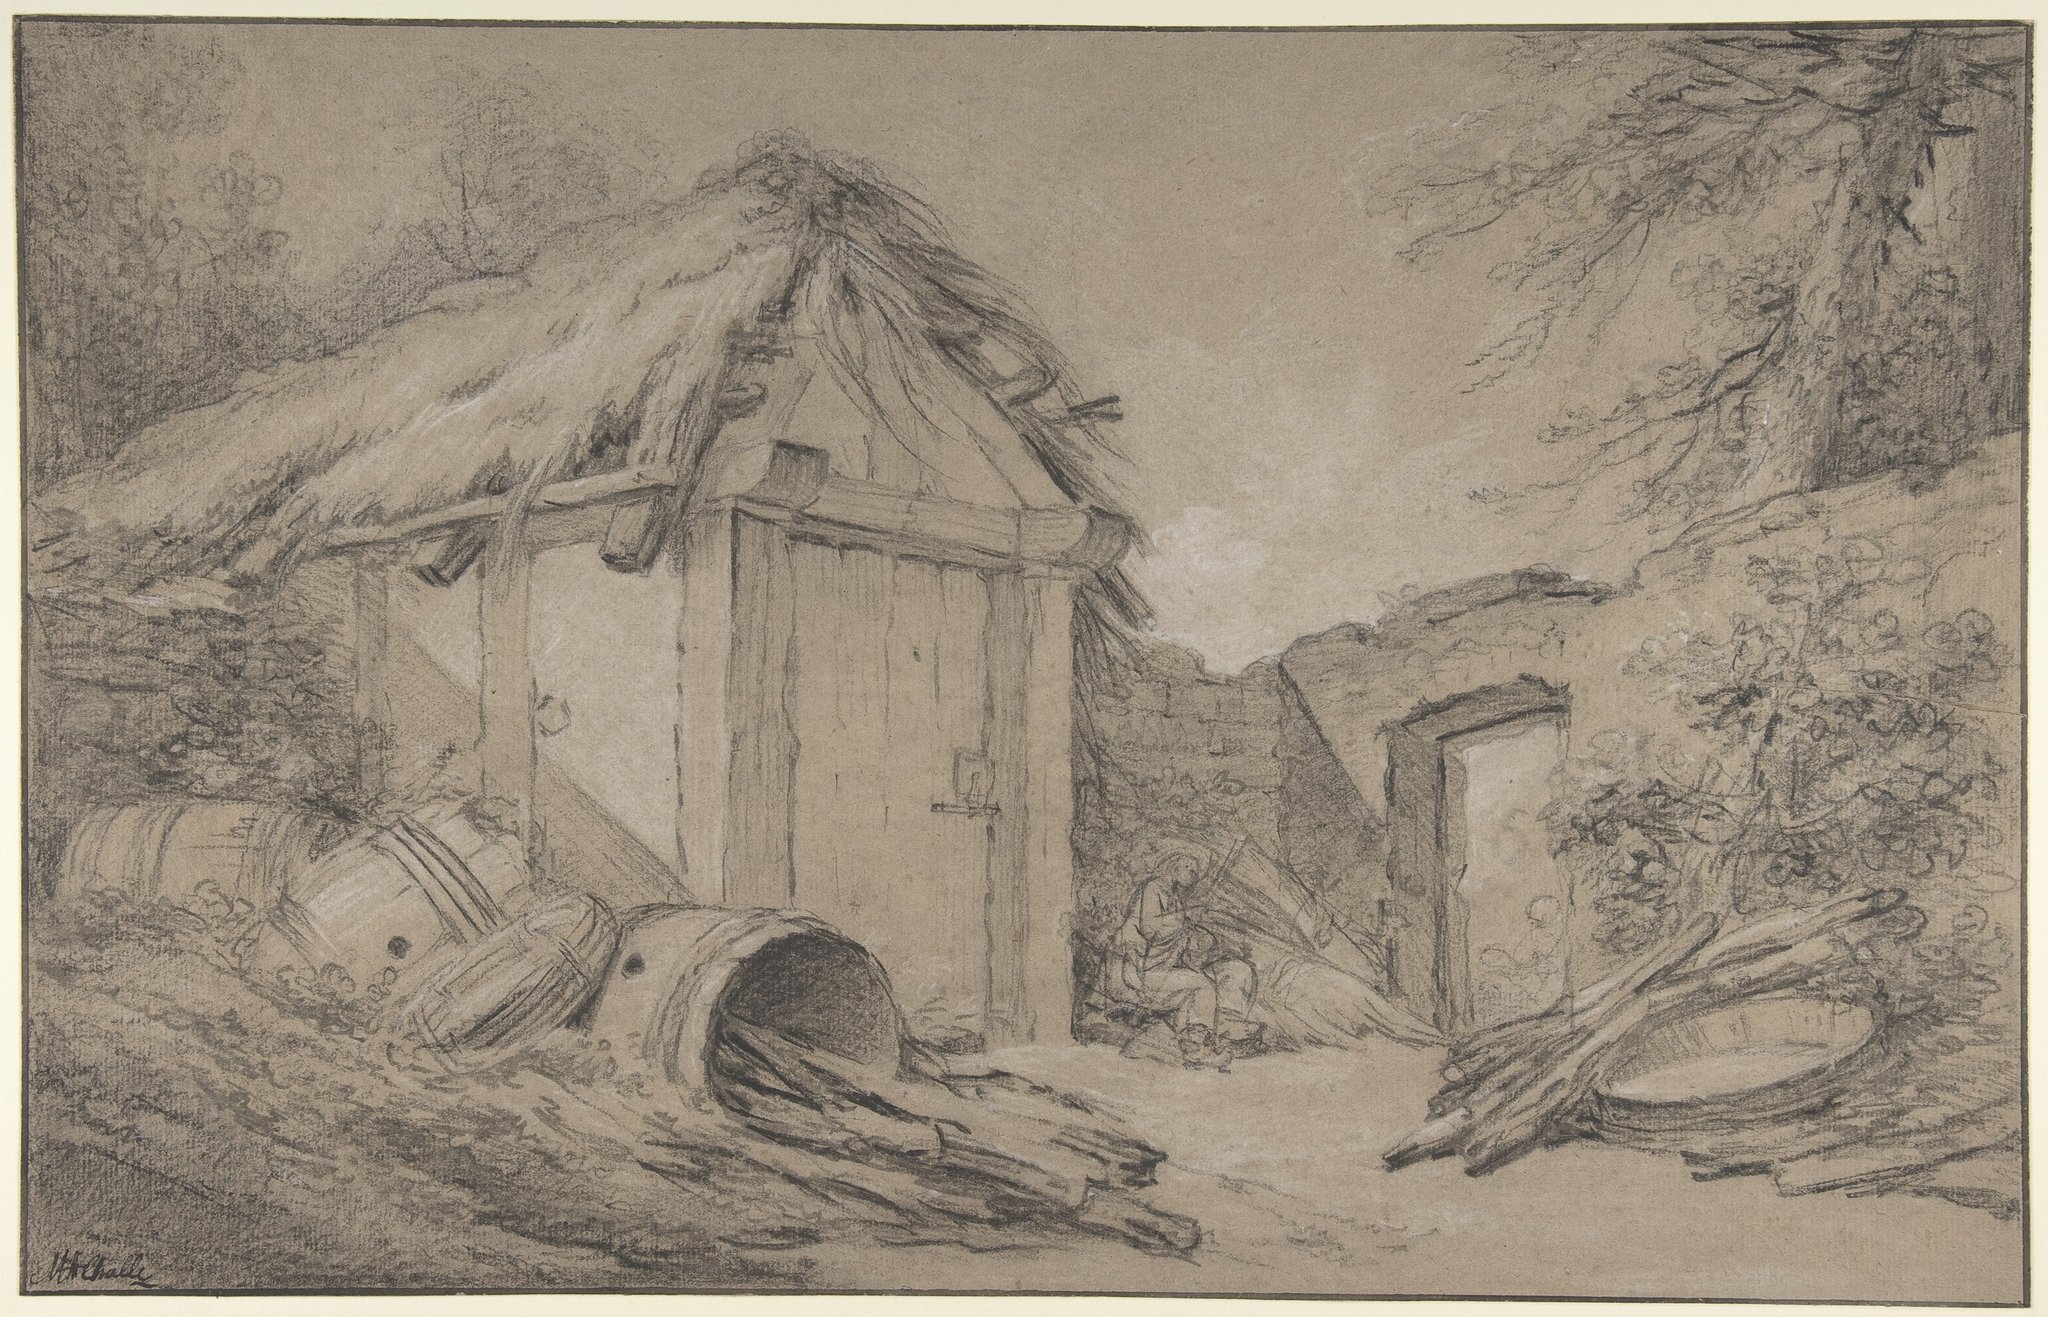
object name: drawing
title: Farmyard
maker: charles michel ange challe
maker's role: artist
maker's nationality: french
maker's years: 1718-1778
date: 1734-1766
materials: chalk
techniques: printmaking, wash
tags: houses,farms,trees